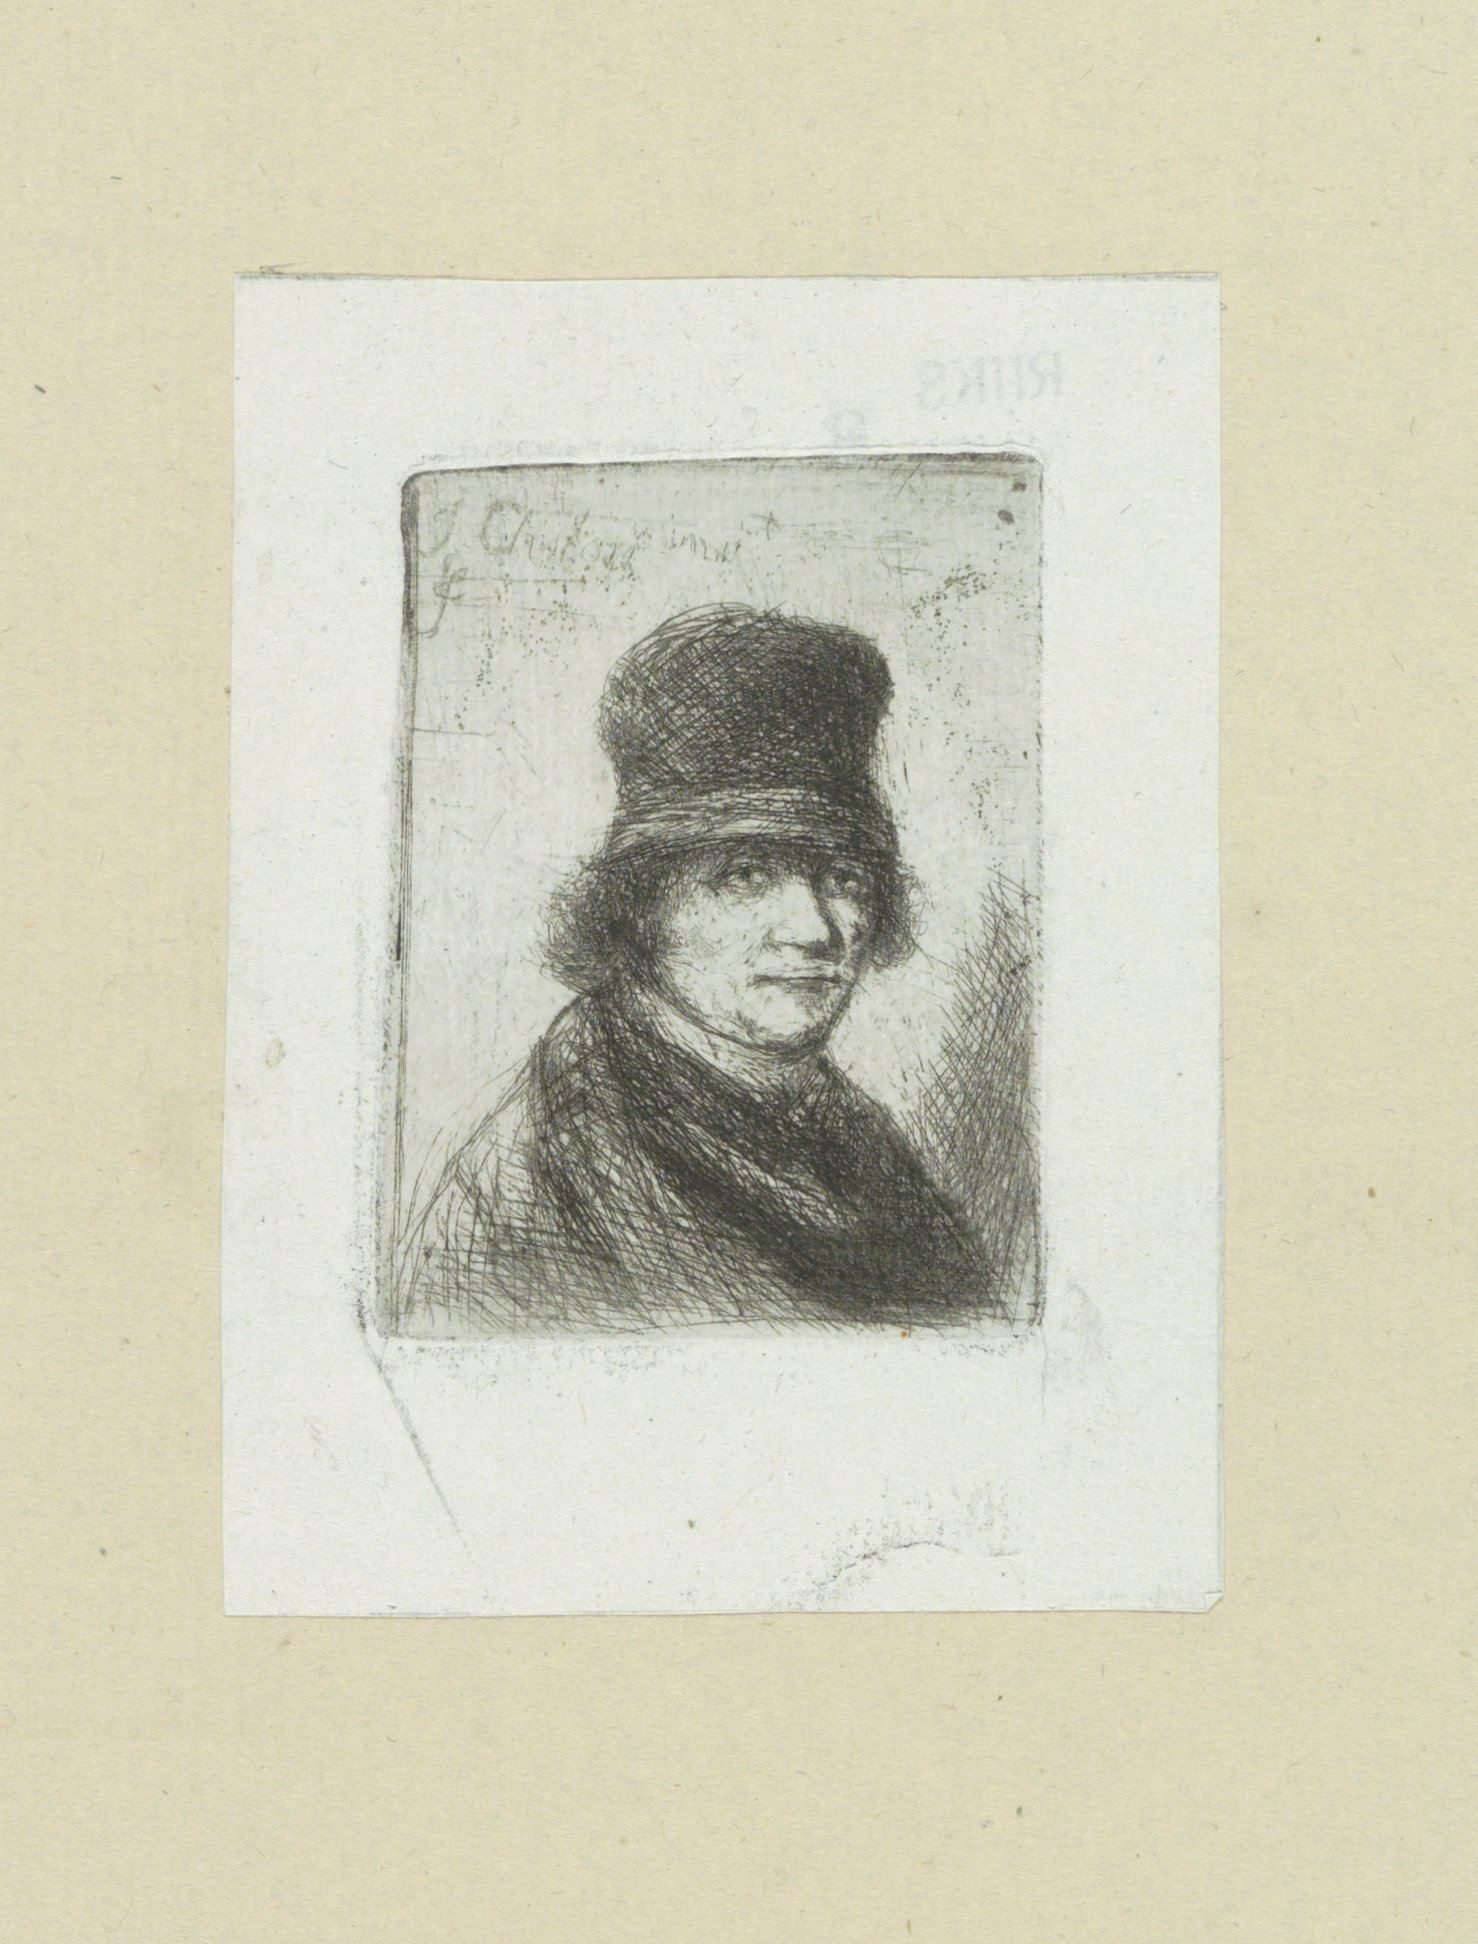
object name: album leaf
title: Man met hoge hoed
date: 1802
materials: paper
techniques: drypoint, etching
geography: london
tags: morphology of human expression (+ adult male (human being))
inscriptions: collector's mark: ‘RIJKS / MUSM’, collector's mark: ‘B’